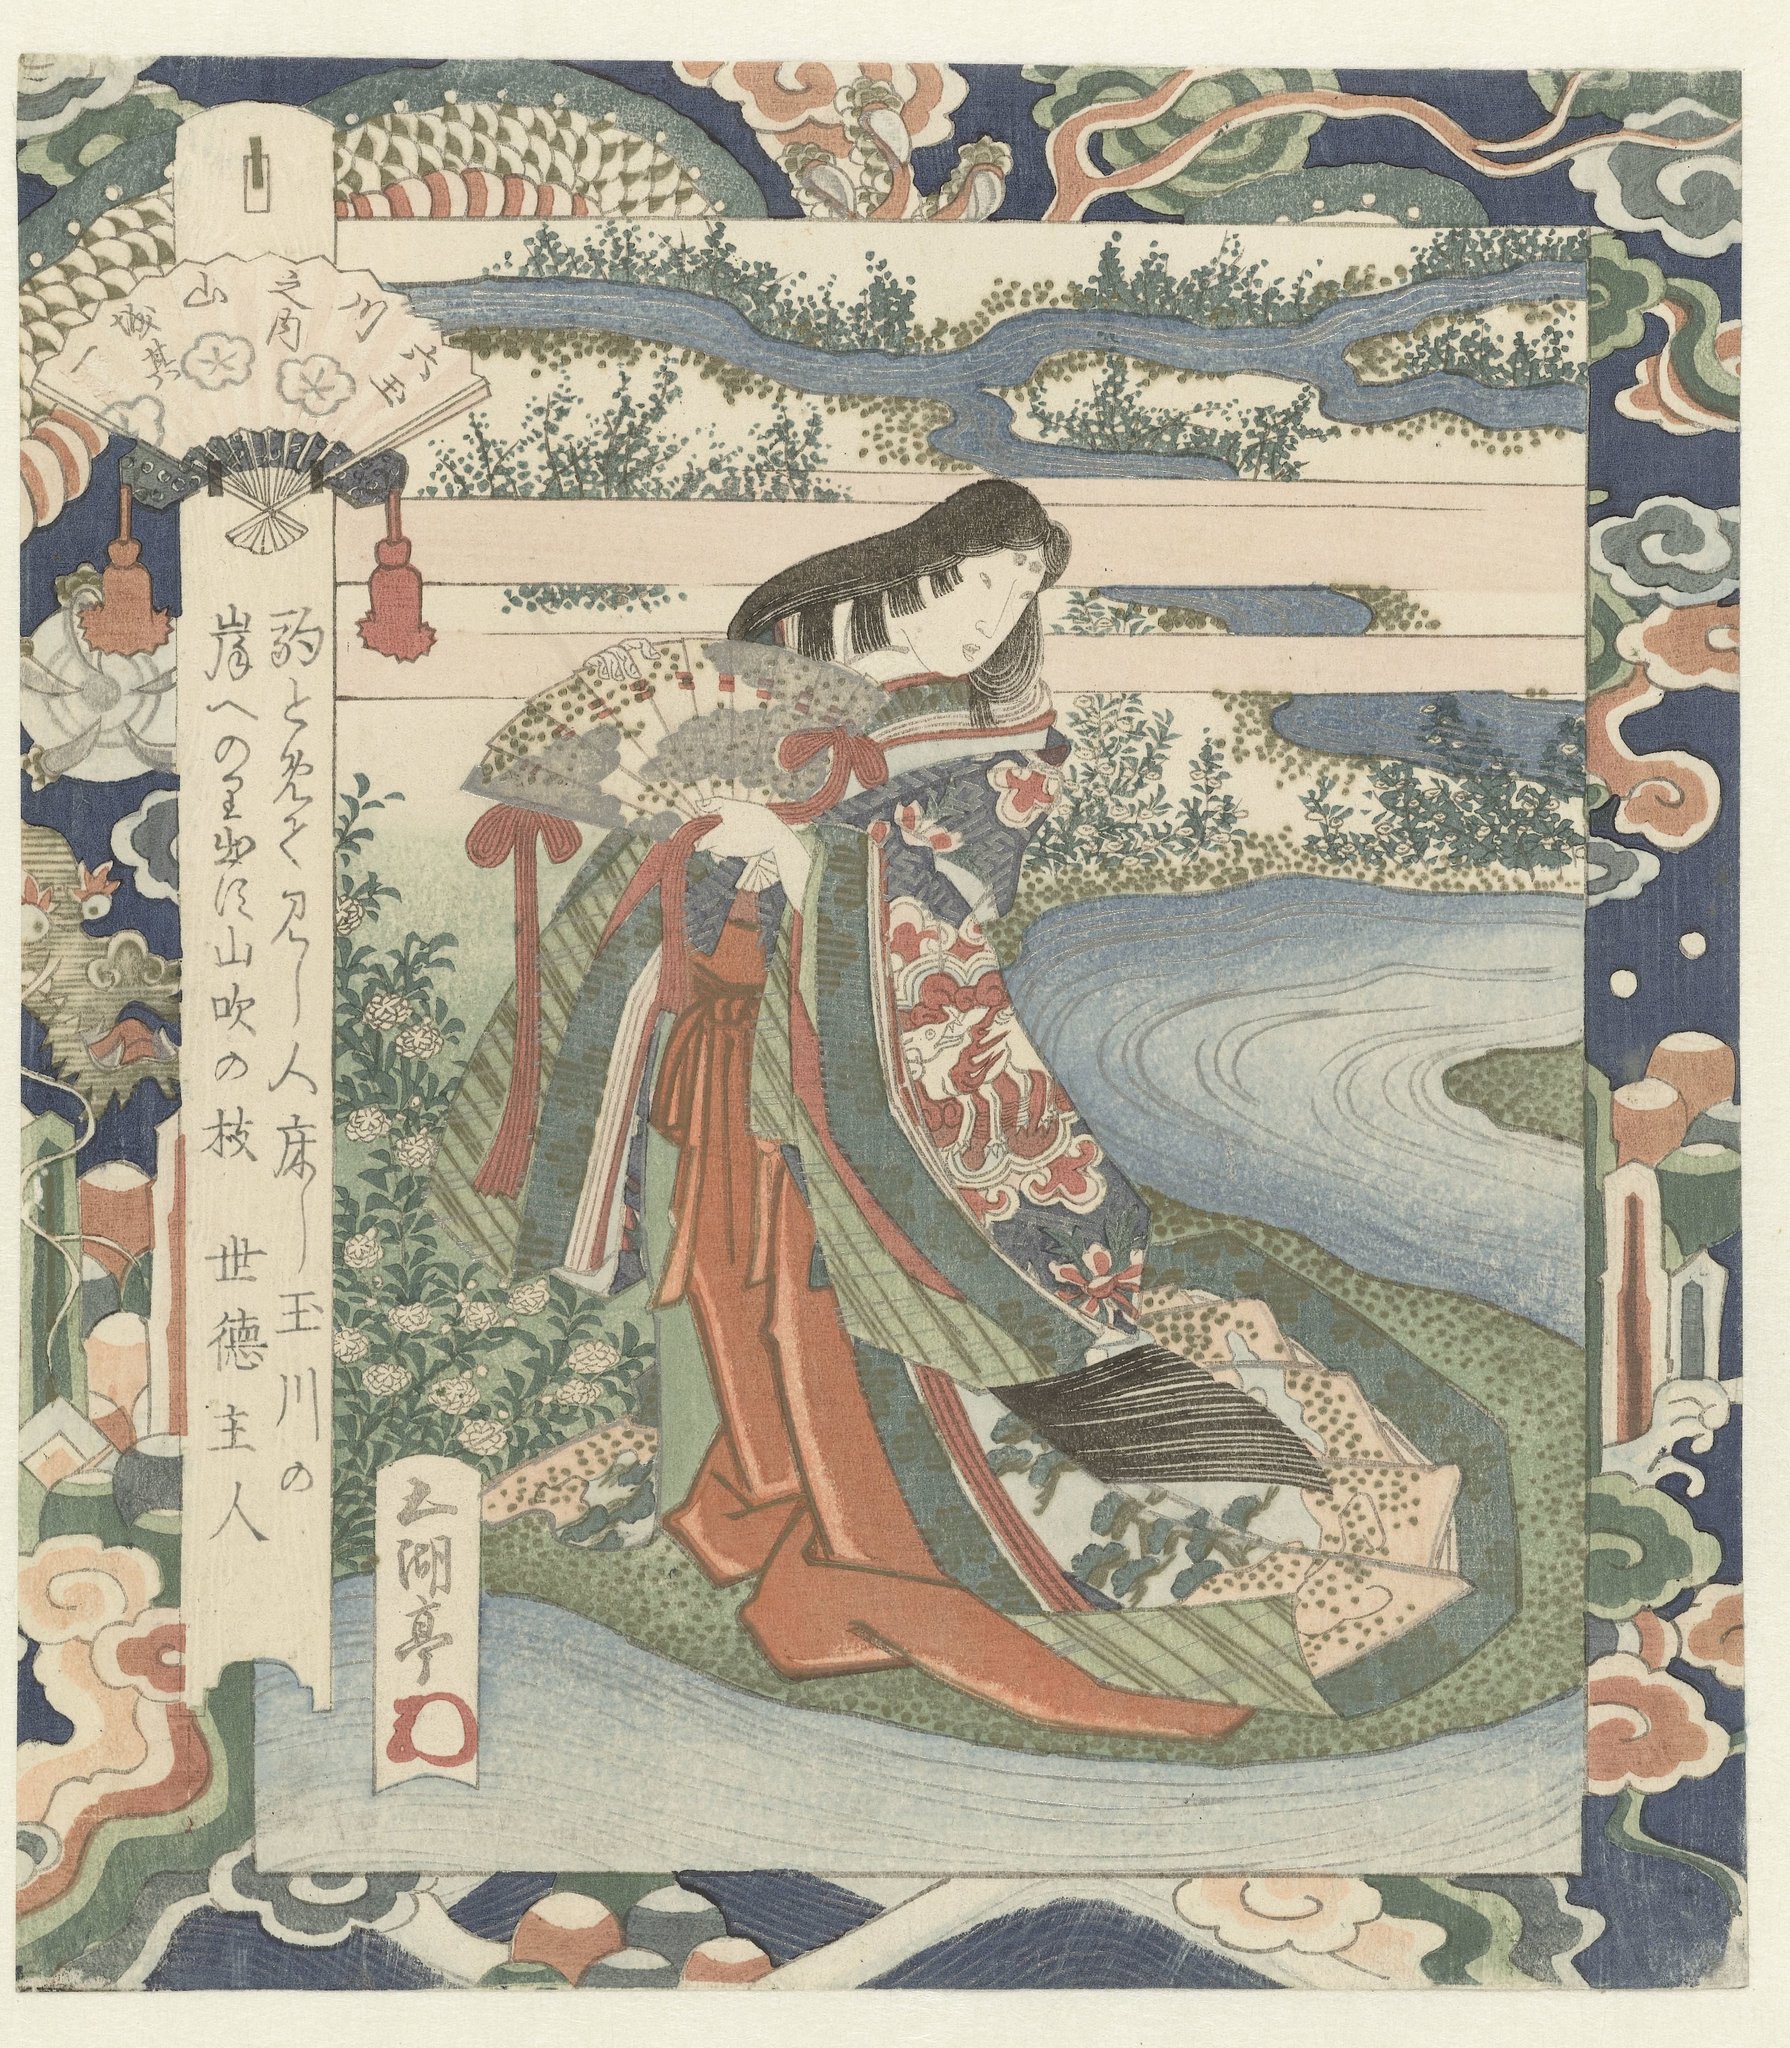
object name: surimono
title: Yamashiro - sono ichi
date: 1832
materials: paper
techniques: blind stamped, woodcut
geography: japan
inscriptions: collector's mark, verso, stamped: Lugt 2228, collector's mark, passe-partout, bottom left, printed: JABdH with a rooster.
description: Een surimono is een luxe uitgevoerde prent waarop beeld met één of meerdere gedichten gecombineerd is. Bij het drukken van een surimono werd vaak gebruik gemaakt van dikker papier, blinddruk en metaal pigmenten, zoals koper- en zilverpoeder. De prenten werden vaak in opdracht van dichters gemaakt en als exclusief geschenk aan vrienden en relaties gegeven.